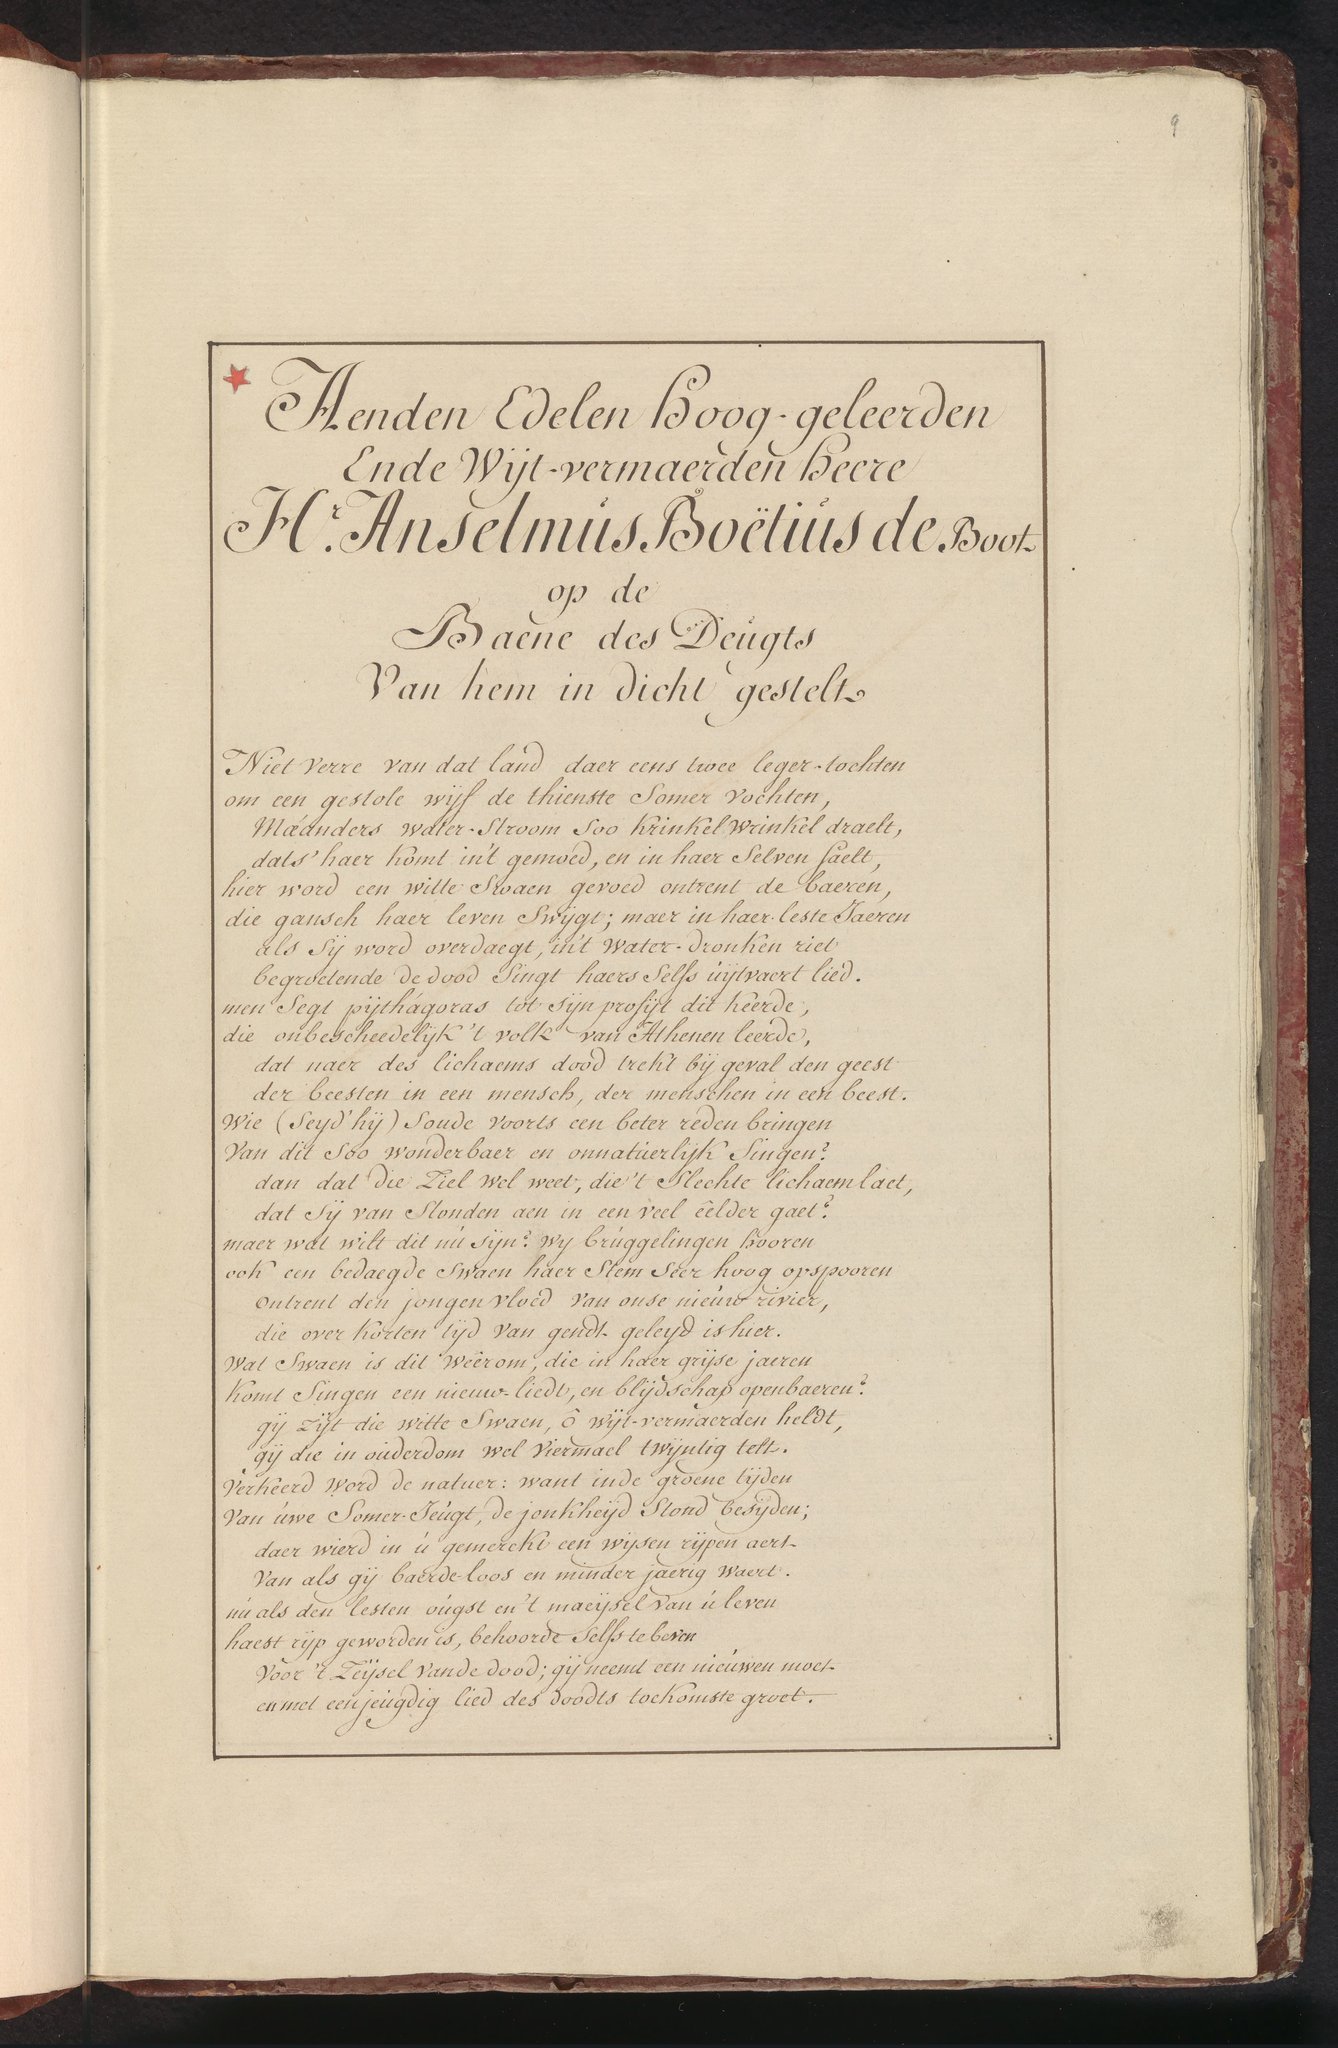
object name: manuscript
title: Lofdicht op Anselmus de Boodt (eerste blad)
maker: francois pierre joseph de gheselle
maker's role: dichter, klerk, schrijver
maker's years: 1773-1840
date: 1790-1814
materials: ink, paper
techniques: handwriting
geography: bruges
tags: bruges, draughtsman, anselmus boëtius de boodt, handwriting, written text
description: Lofdicht op Anselmus de Boodt op vijf bladen (eerste blad). Onderdeel van het eerste album met tekeningen van viervoeters. Eerste van twaalf albums met tekeningen van dieren, vogels en planten bekend rond 1600, gemaakt in opdracht van keizer Rudolf II. Met toelichting in Nederlands, Latijn en Frans.